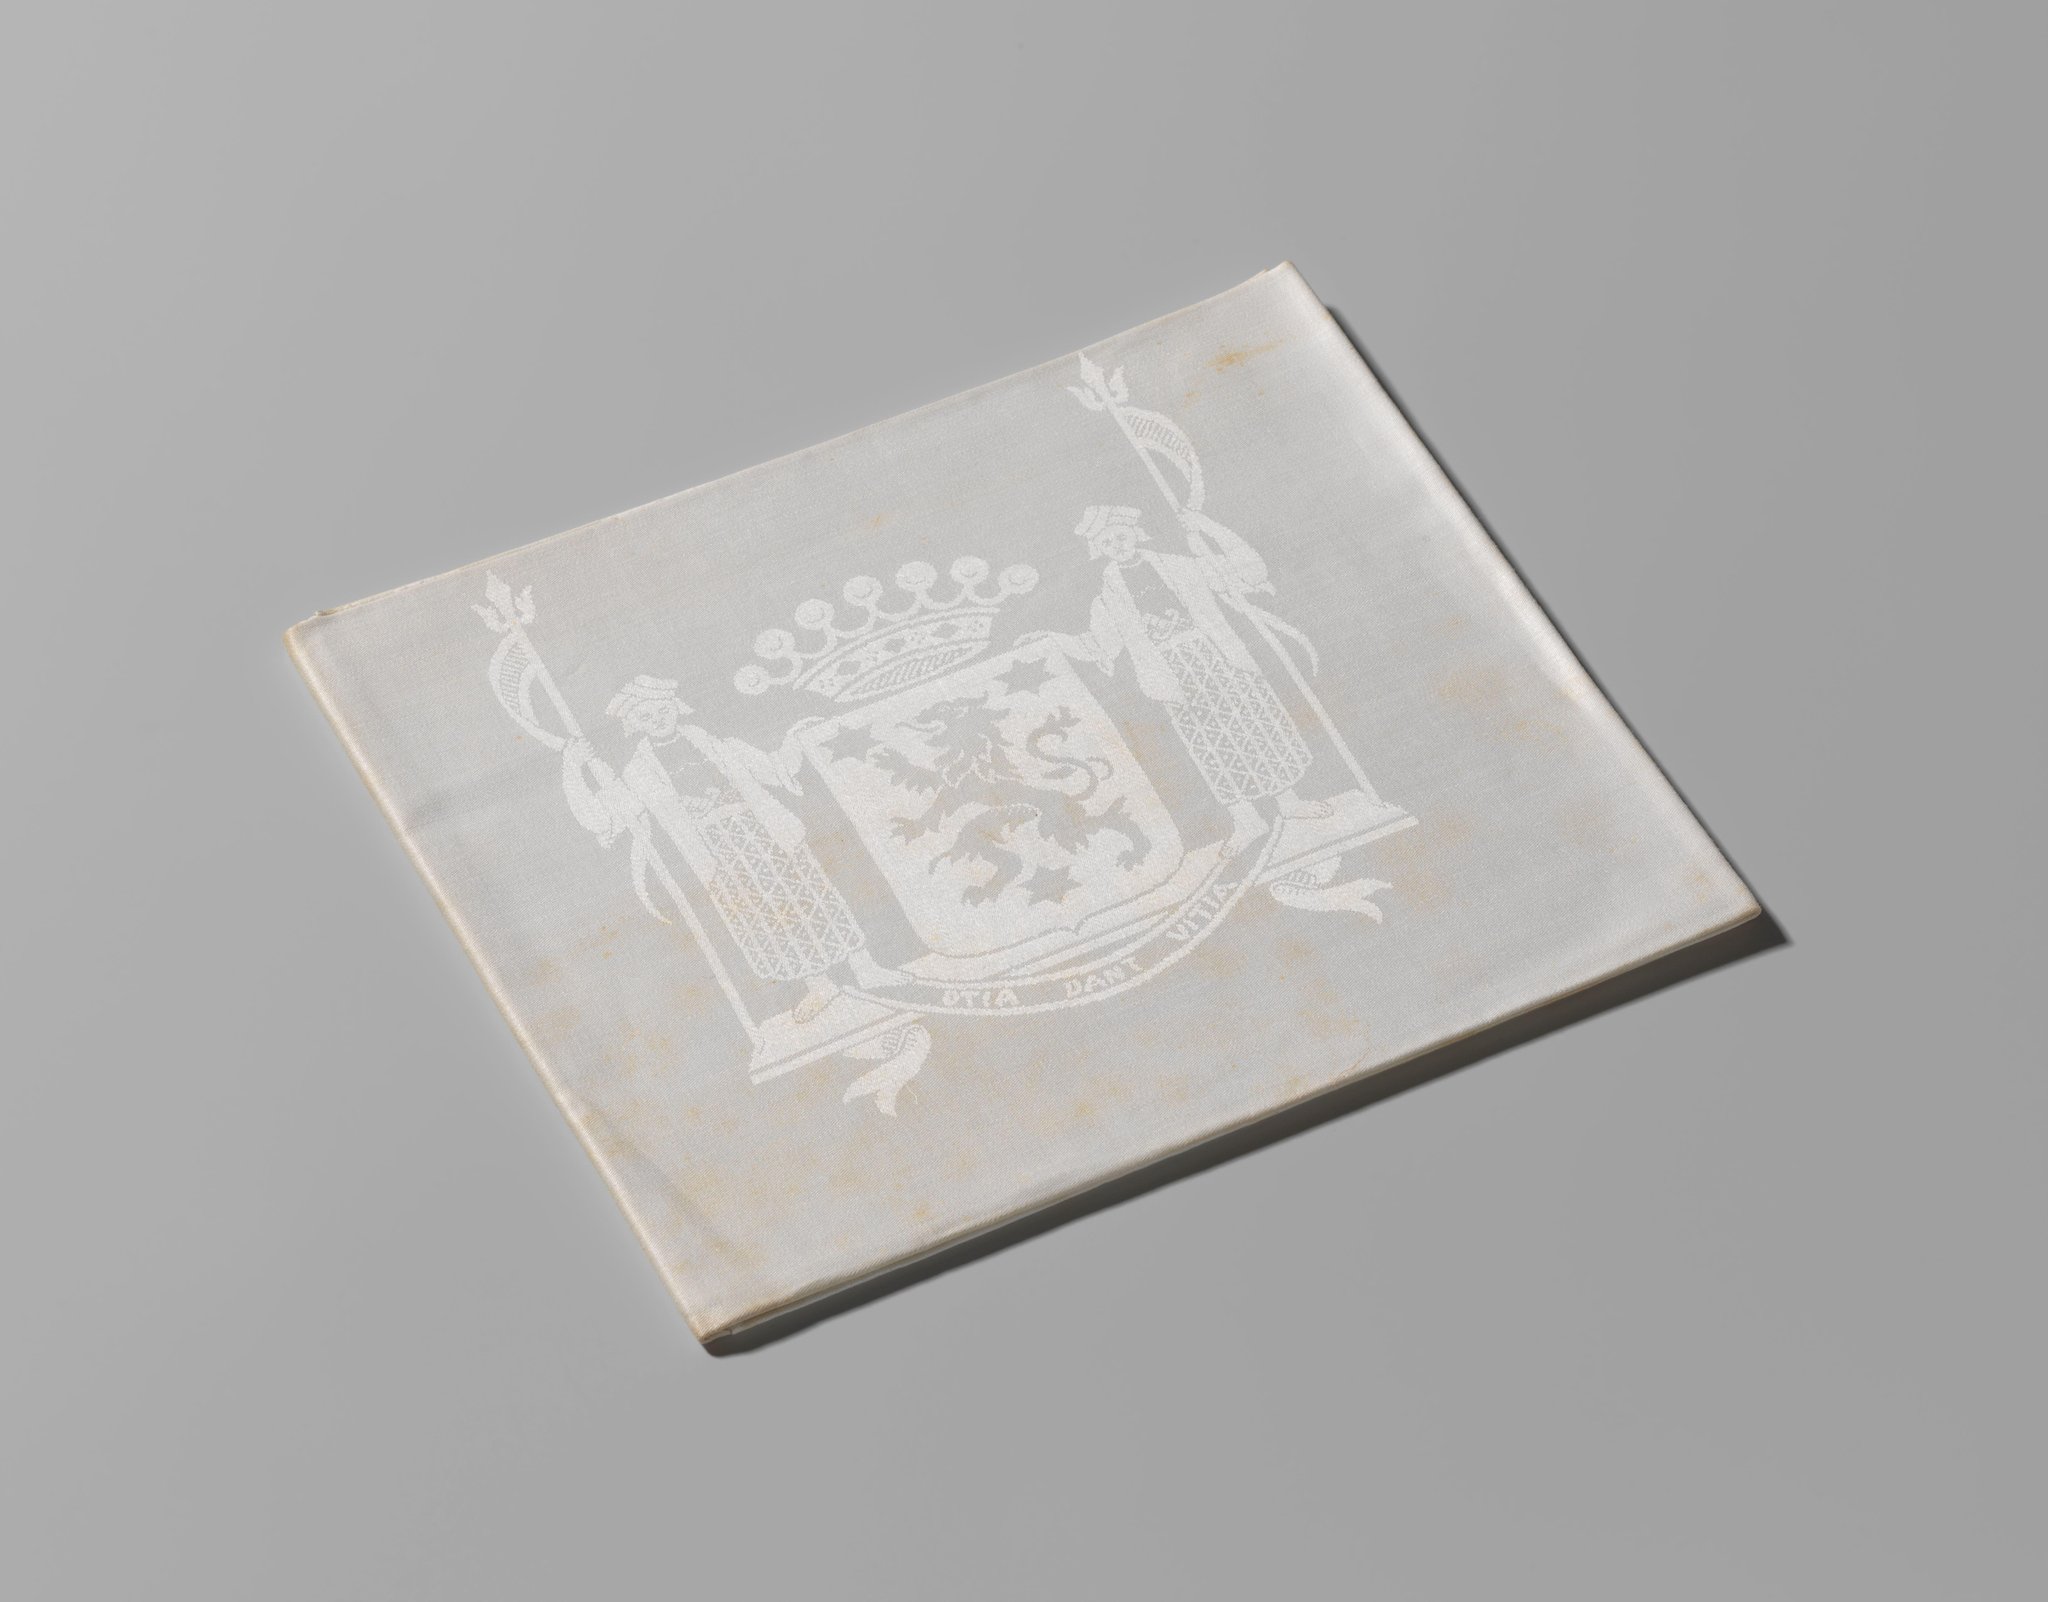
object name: napkin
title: Servet van wit linnendamast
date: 1852-1889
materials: linen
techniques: damask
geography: veghel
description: Wit linnen damasten servet met eikentakken en het wapen van de baronnen Baud. Gemerkt BvH.